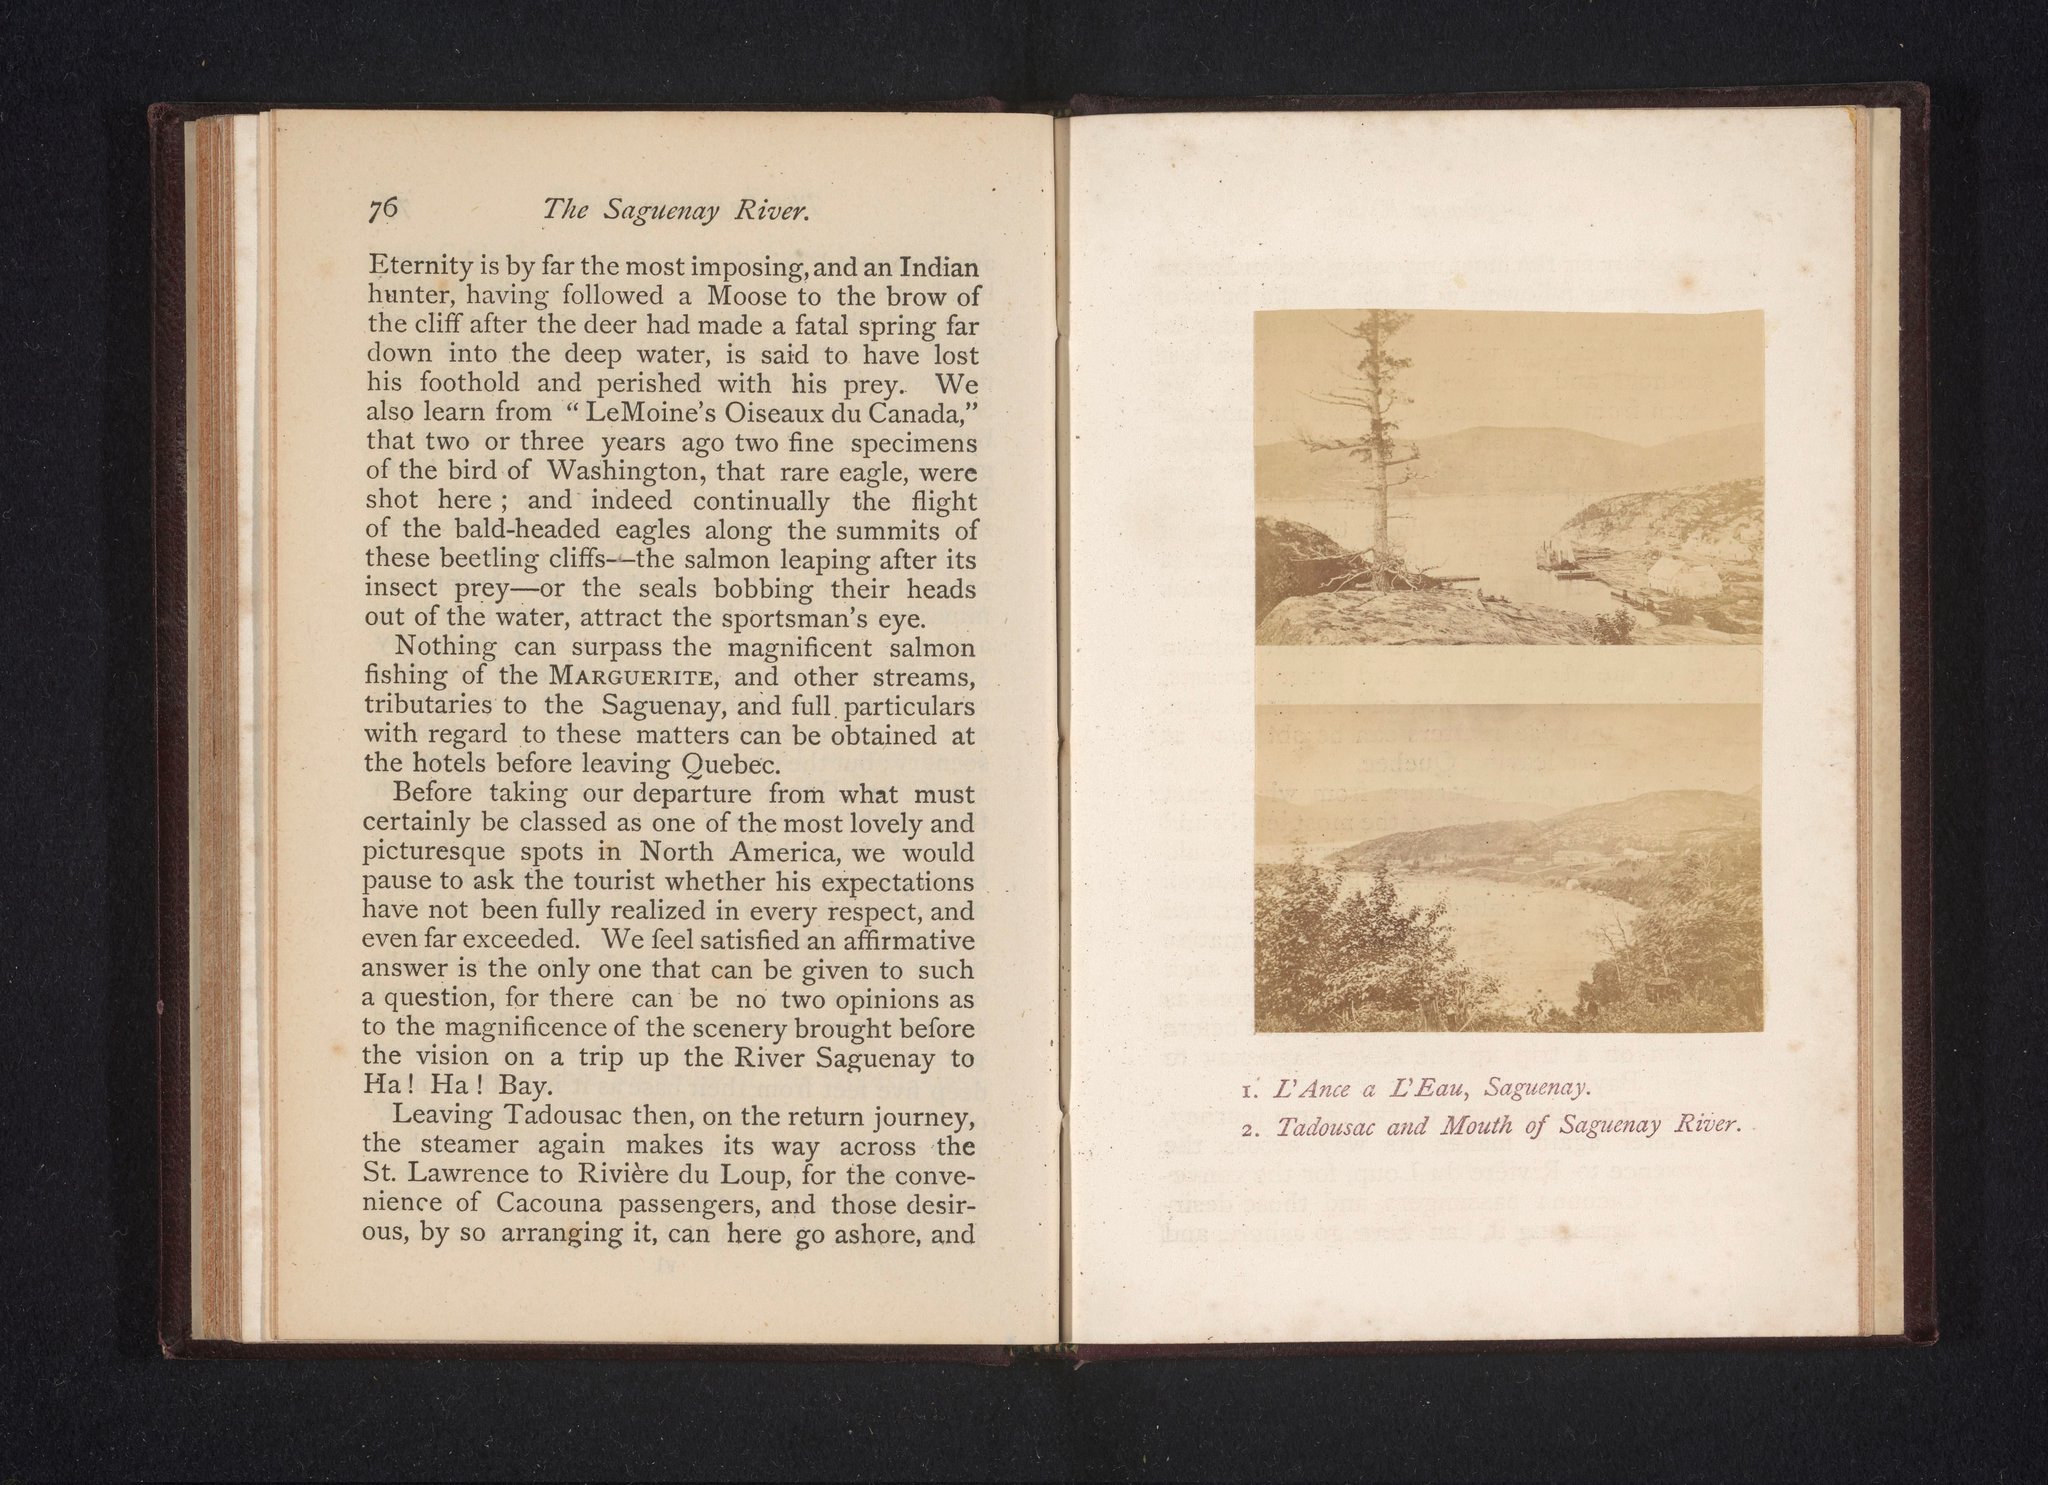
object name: page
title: Tadousac and mouth of Saguenay river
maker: alexander lamont henderson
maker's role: fotograaf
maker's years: 1838-1907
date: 1859-1869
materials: photographic support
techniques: albumen print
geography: canada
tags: city-view in general; 'veduta', river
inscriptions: number: ‘1. 2.’